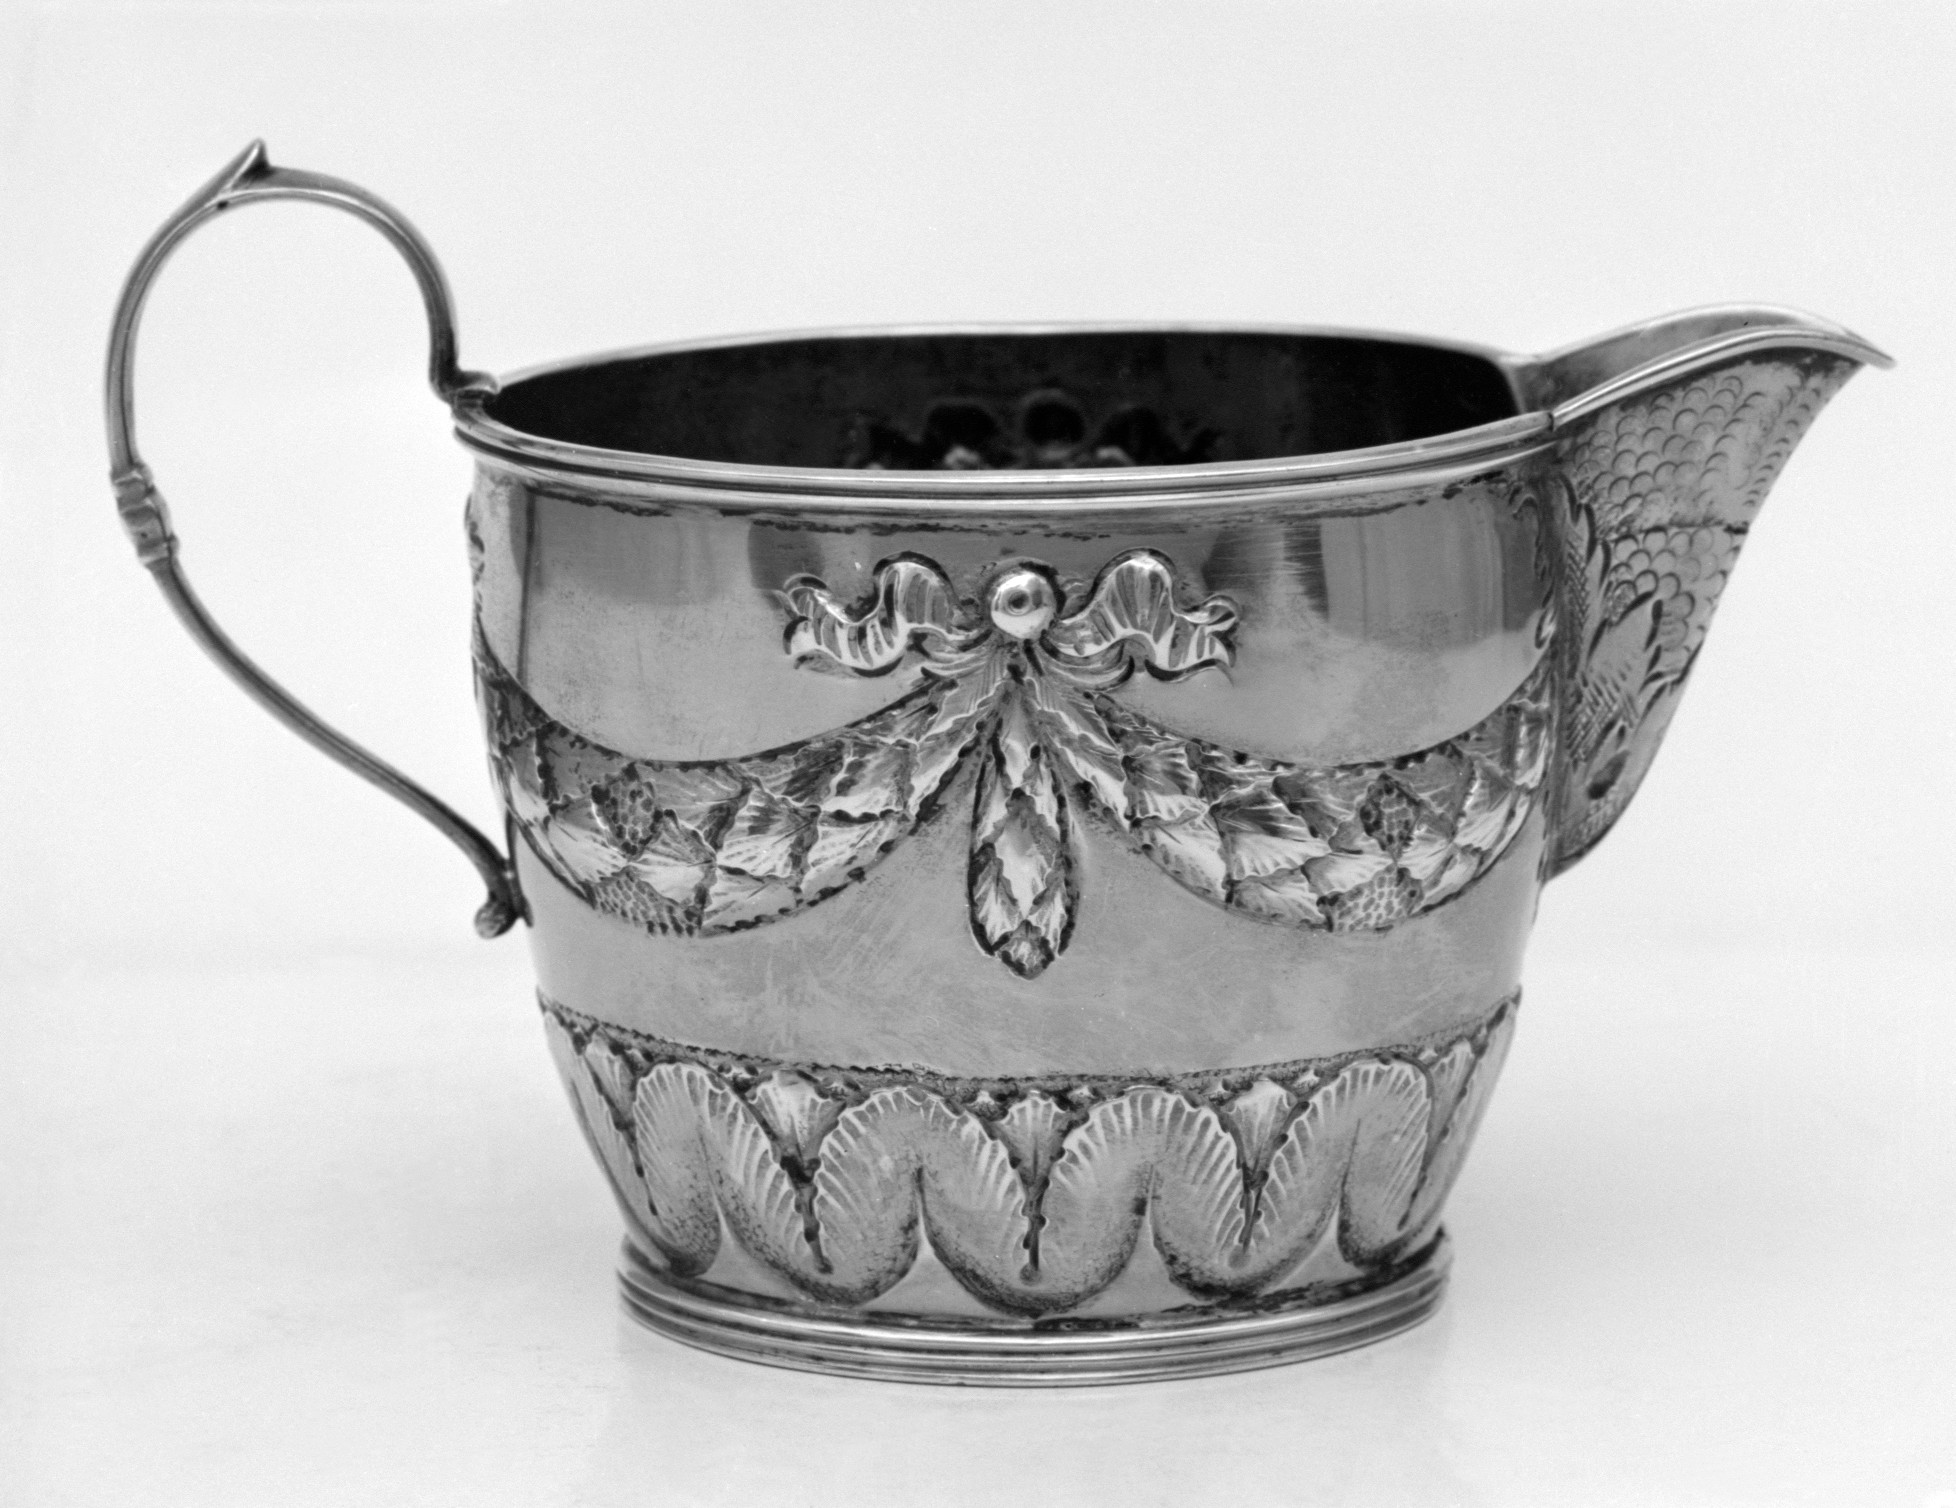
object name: cream jug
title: Cream jug (part of a set)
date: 1808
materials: silver gilt